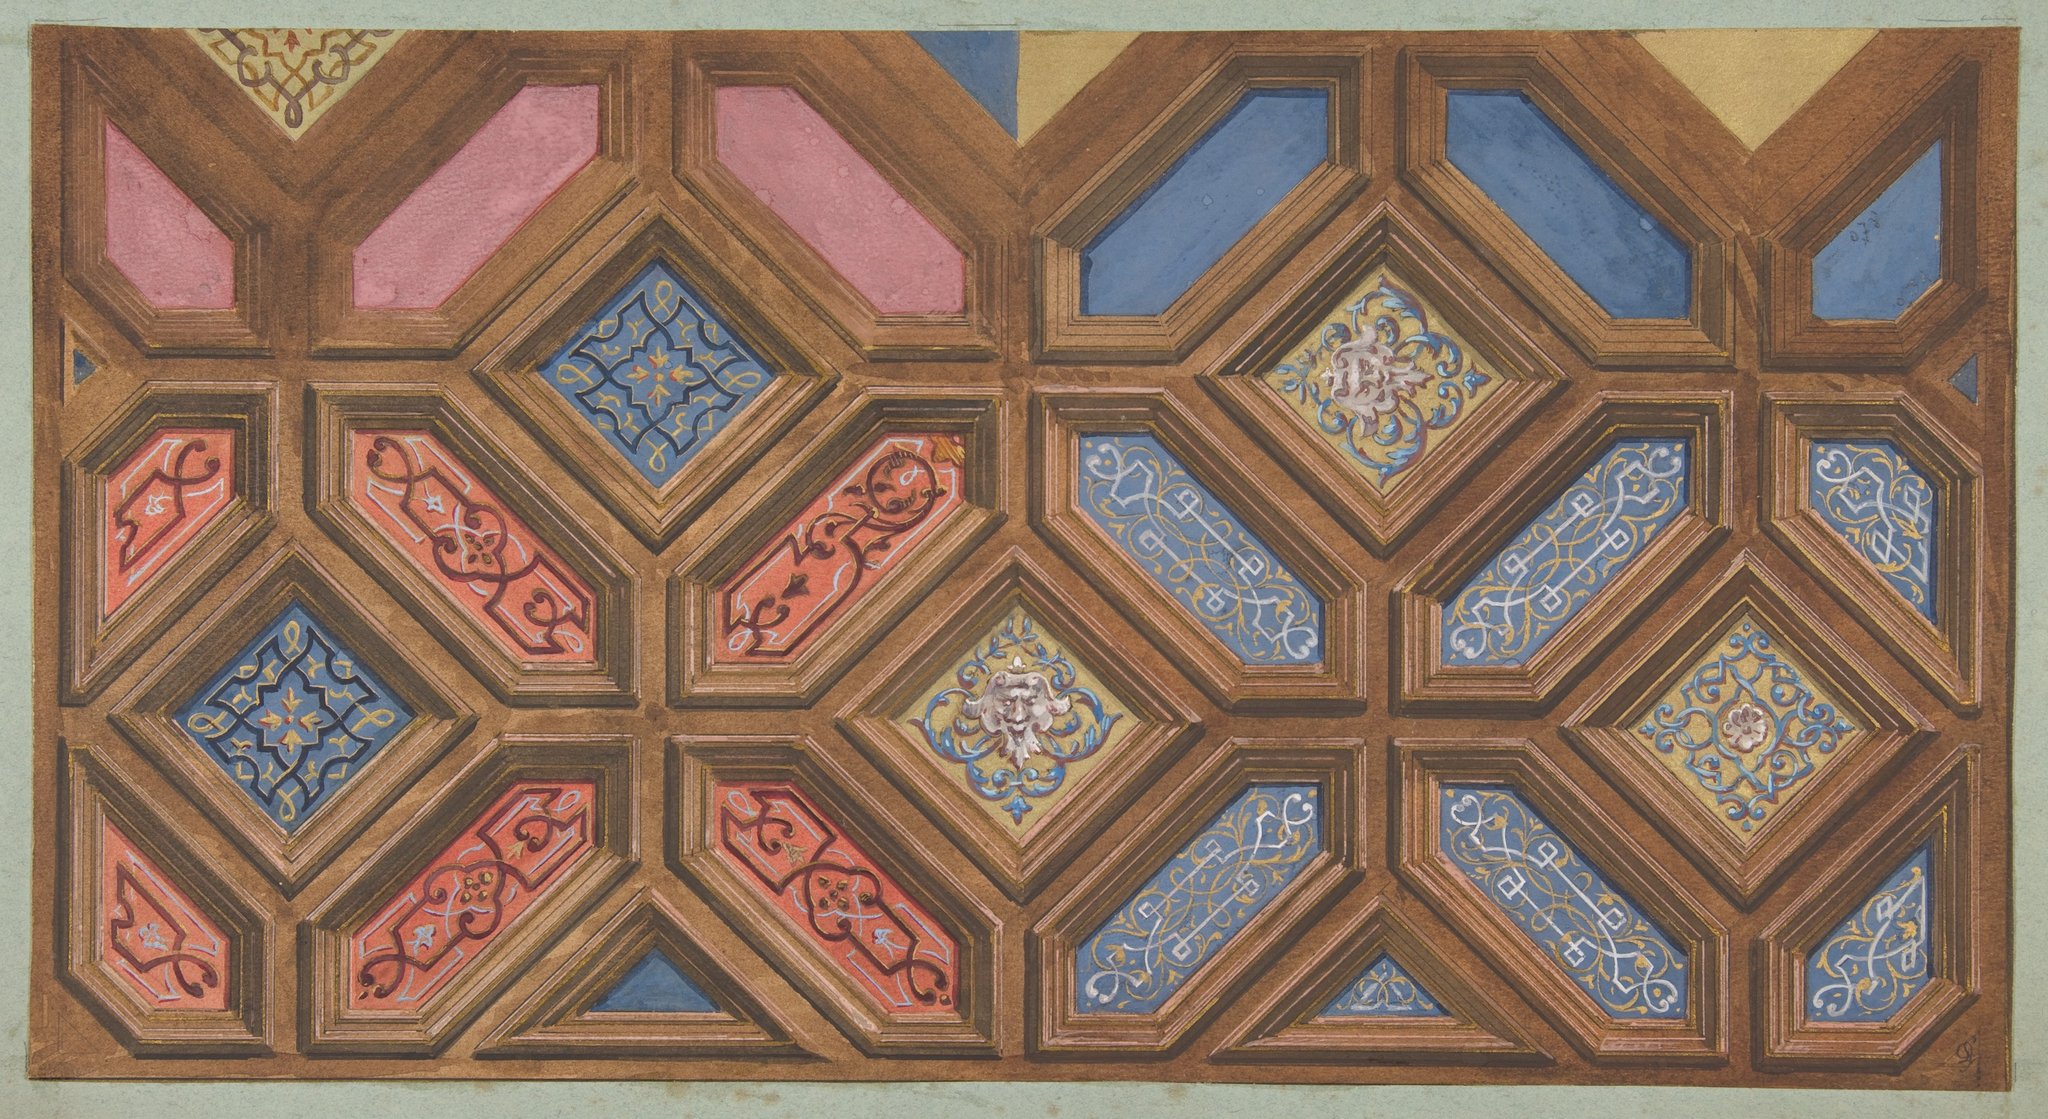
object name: drawing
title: Alternate designs for the decoration of a coffered ceiling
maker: jules-edmond-charles lachaise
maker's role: artist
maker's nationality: french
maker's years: 1897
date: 1840-1897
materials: gold paint, gouache, graphite, ink, paper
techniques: inlay, pen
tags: ceilings